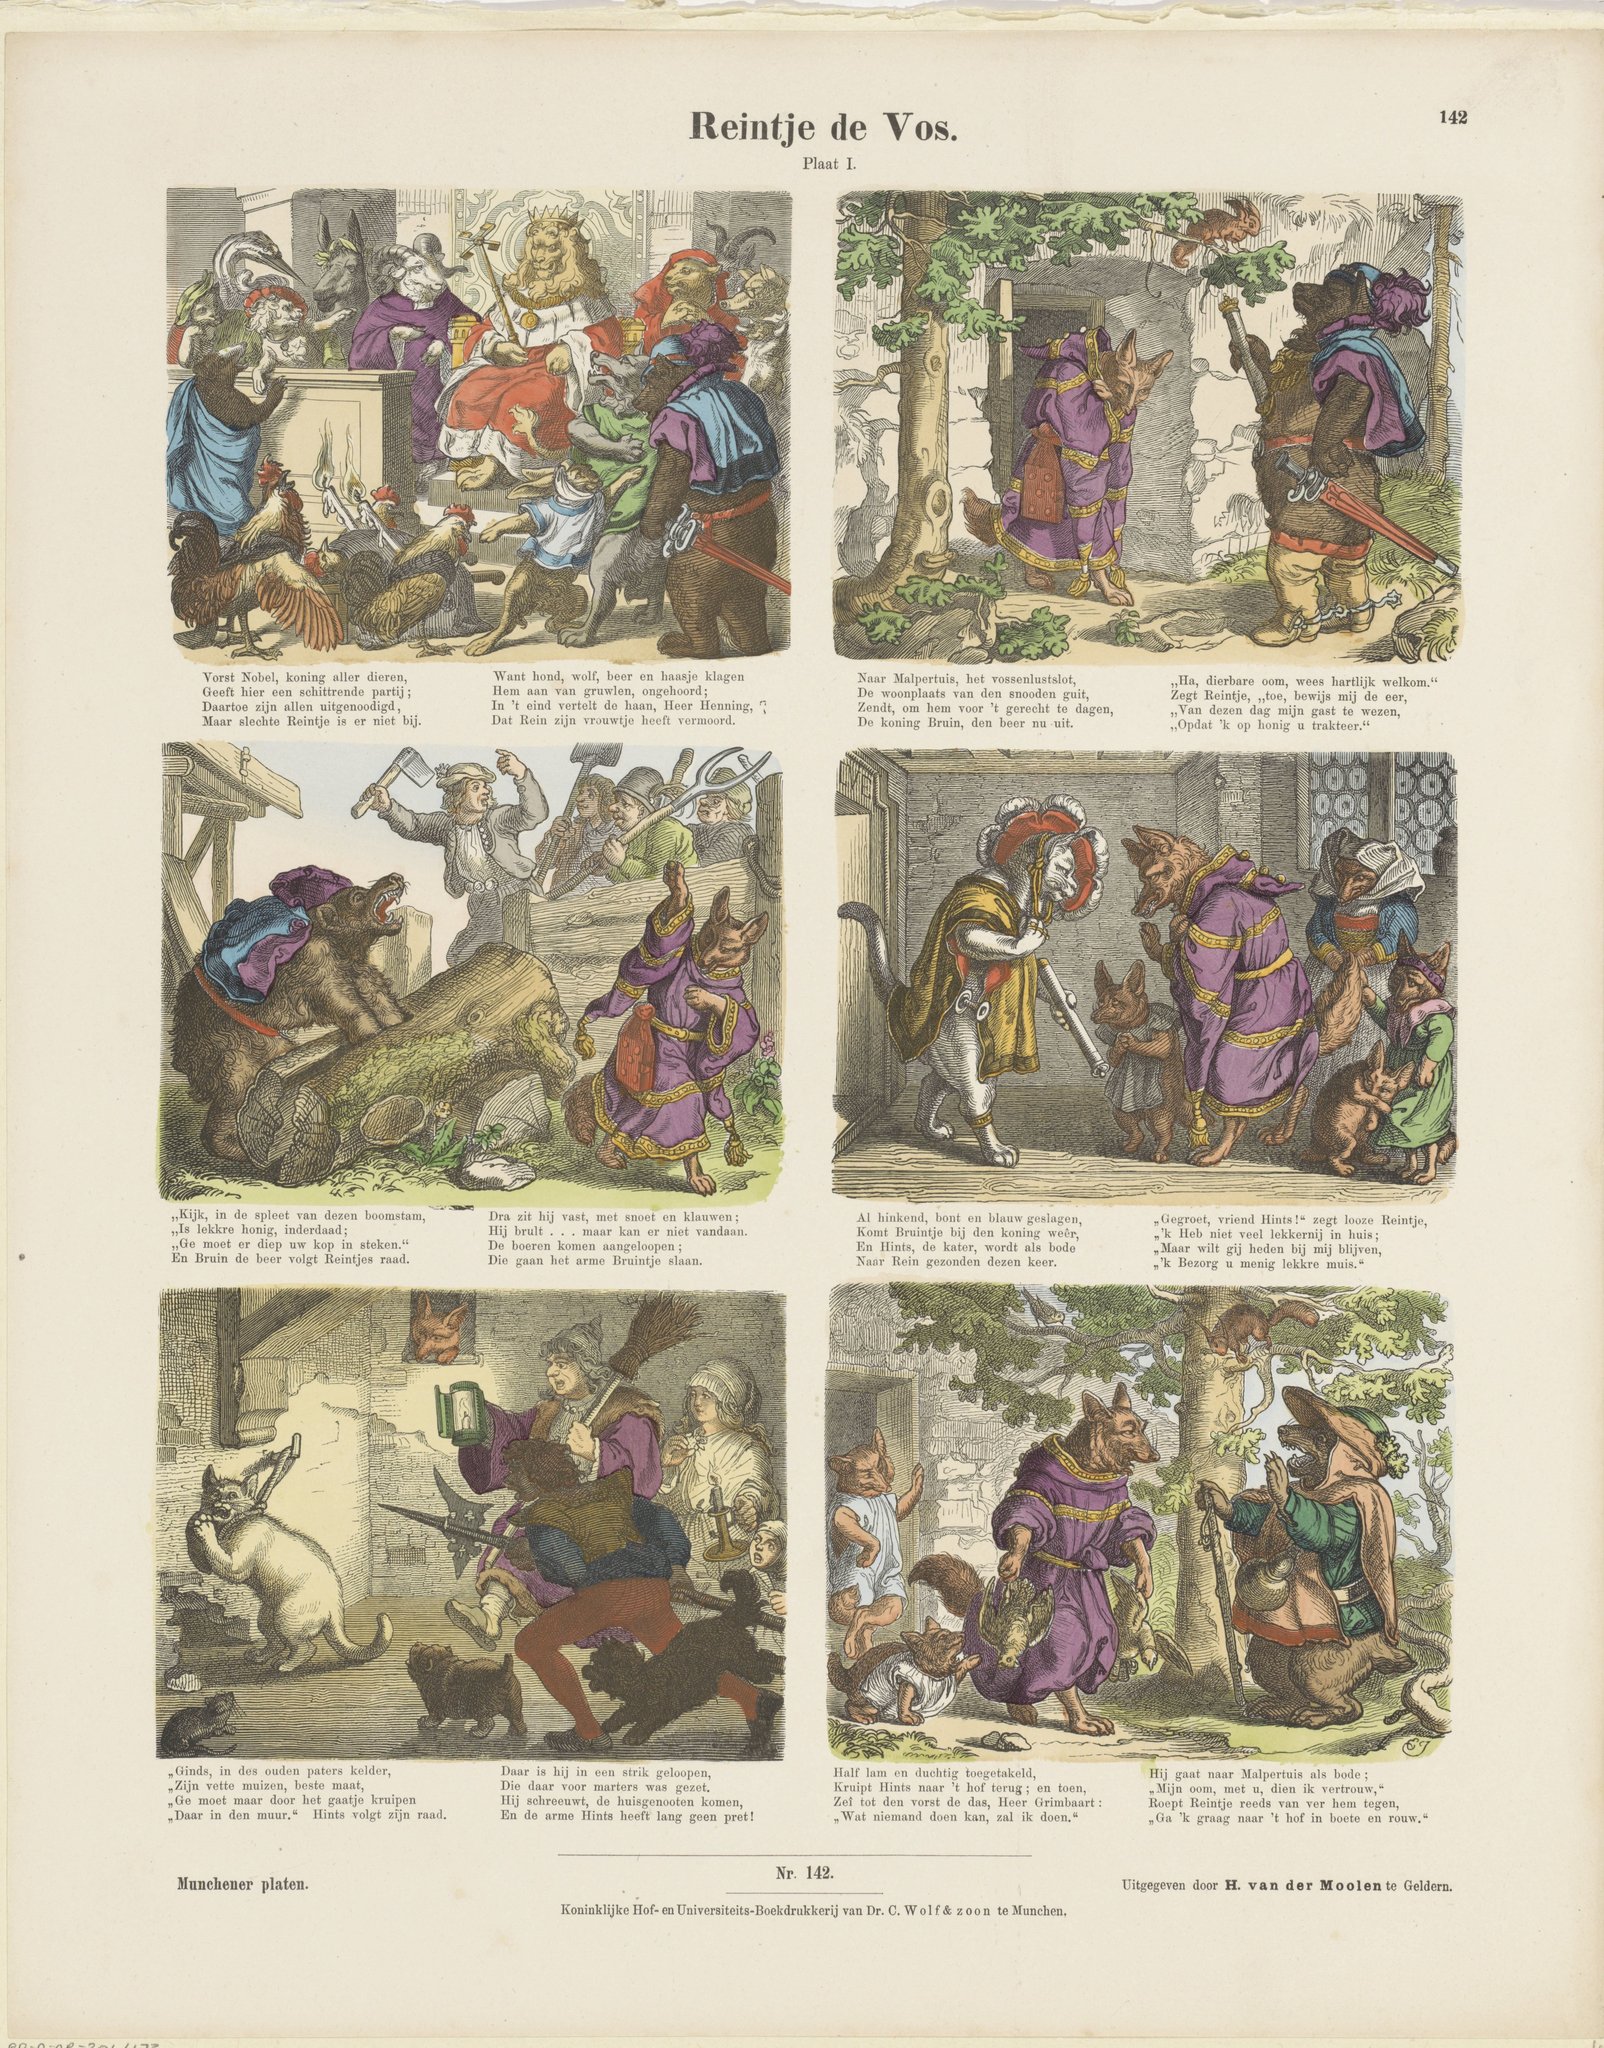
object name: print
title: Reintje de Vos. / Plaat I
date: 1843-1920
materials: paper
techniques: colour, letterpress printing, engraving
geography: germany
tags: fable of reynard the fox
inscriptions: collector's mark: Lugt 2760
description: Blad met 6 voorstellingen uit het epos van Reinaert de vos. Onder elke afbeelding een achtregelig vers in twee kolommen. Genummerd midden onder: Nro. 142. Genummerd rechtsboven: 142.